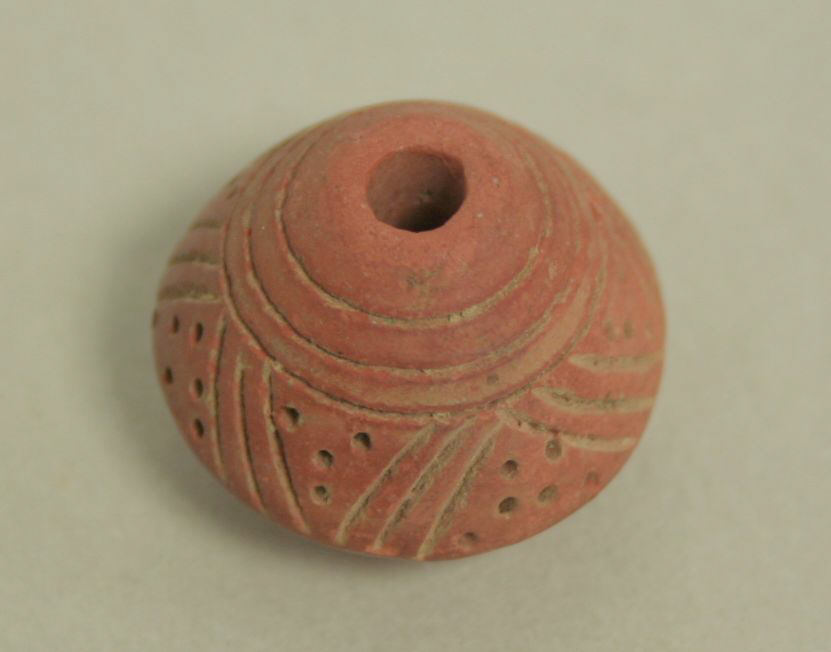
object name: spindle whorl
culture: peruvian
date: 1-500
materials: ceramic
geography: peru